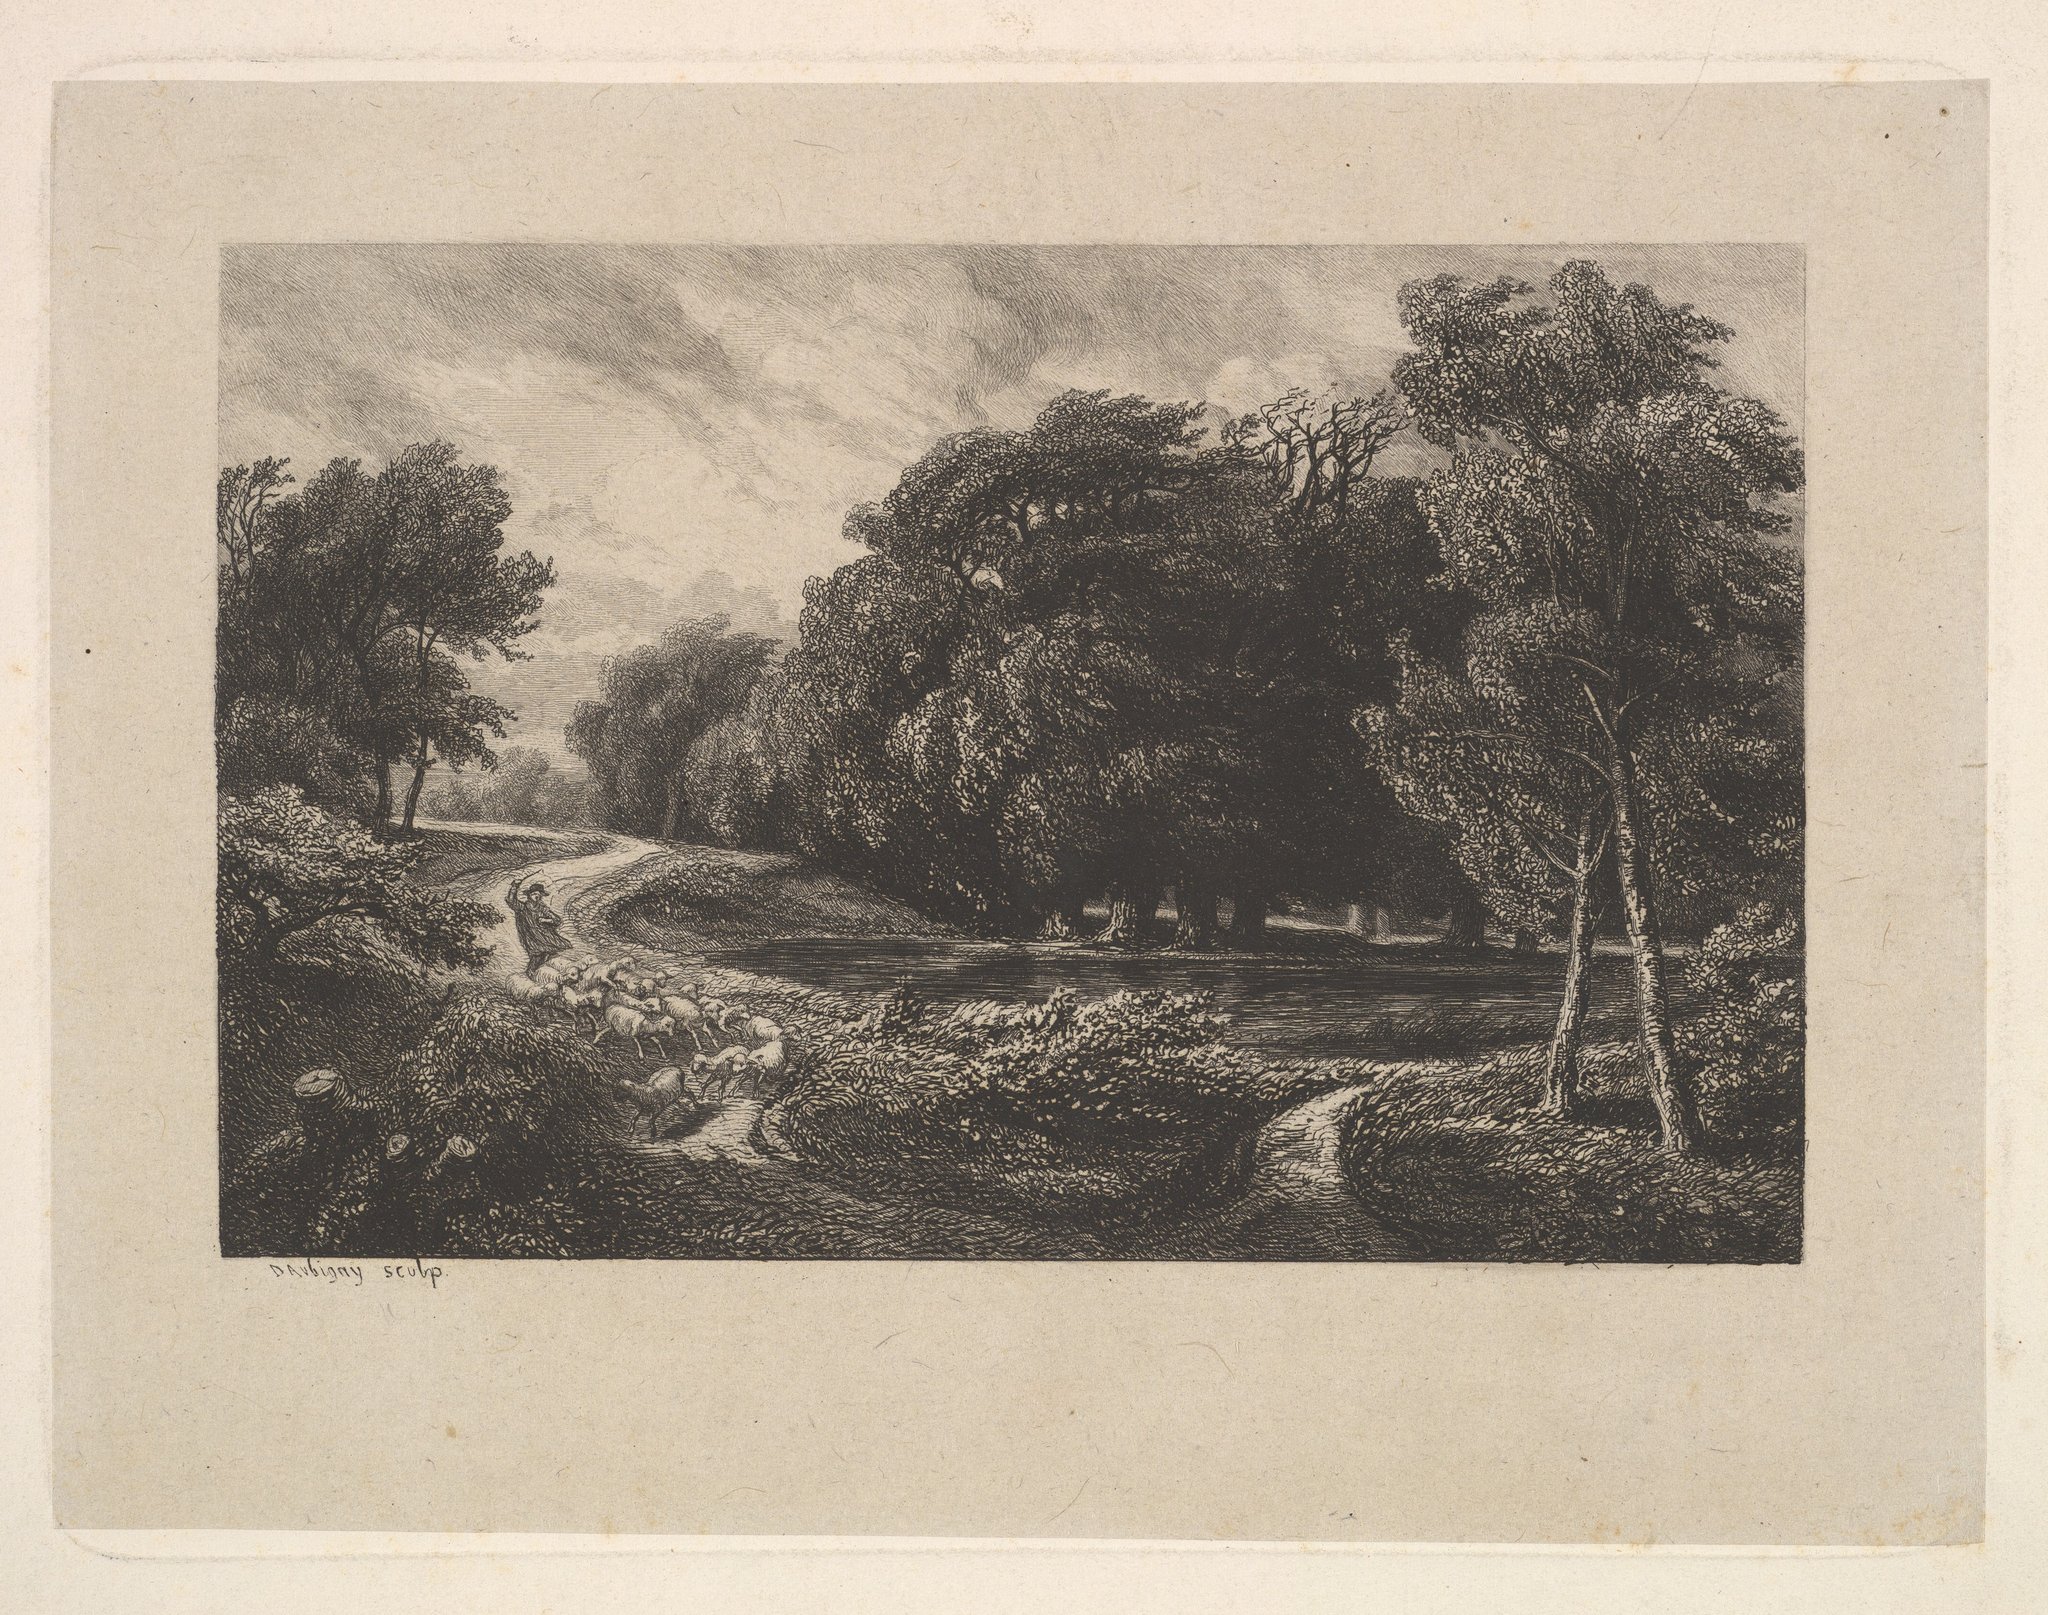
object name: print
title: The Approaching Storm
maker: charles-françois daubigny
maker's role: artist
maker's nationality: french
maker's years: 1817-1878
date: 1844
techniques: printmaking, etching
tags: human figures,animals,roads,trees,storms